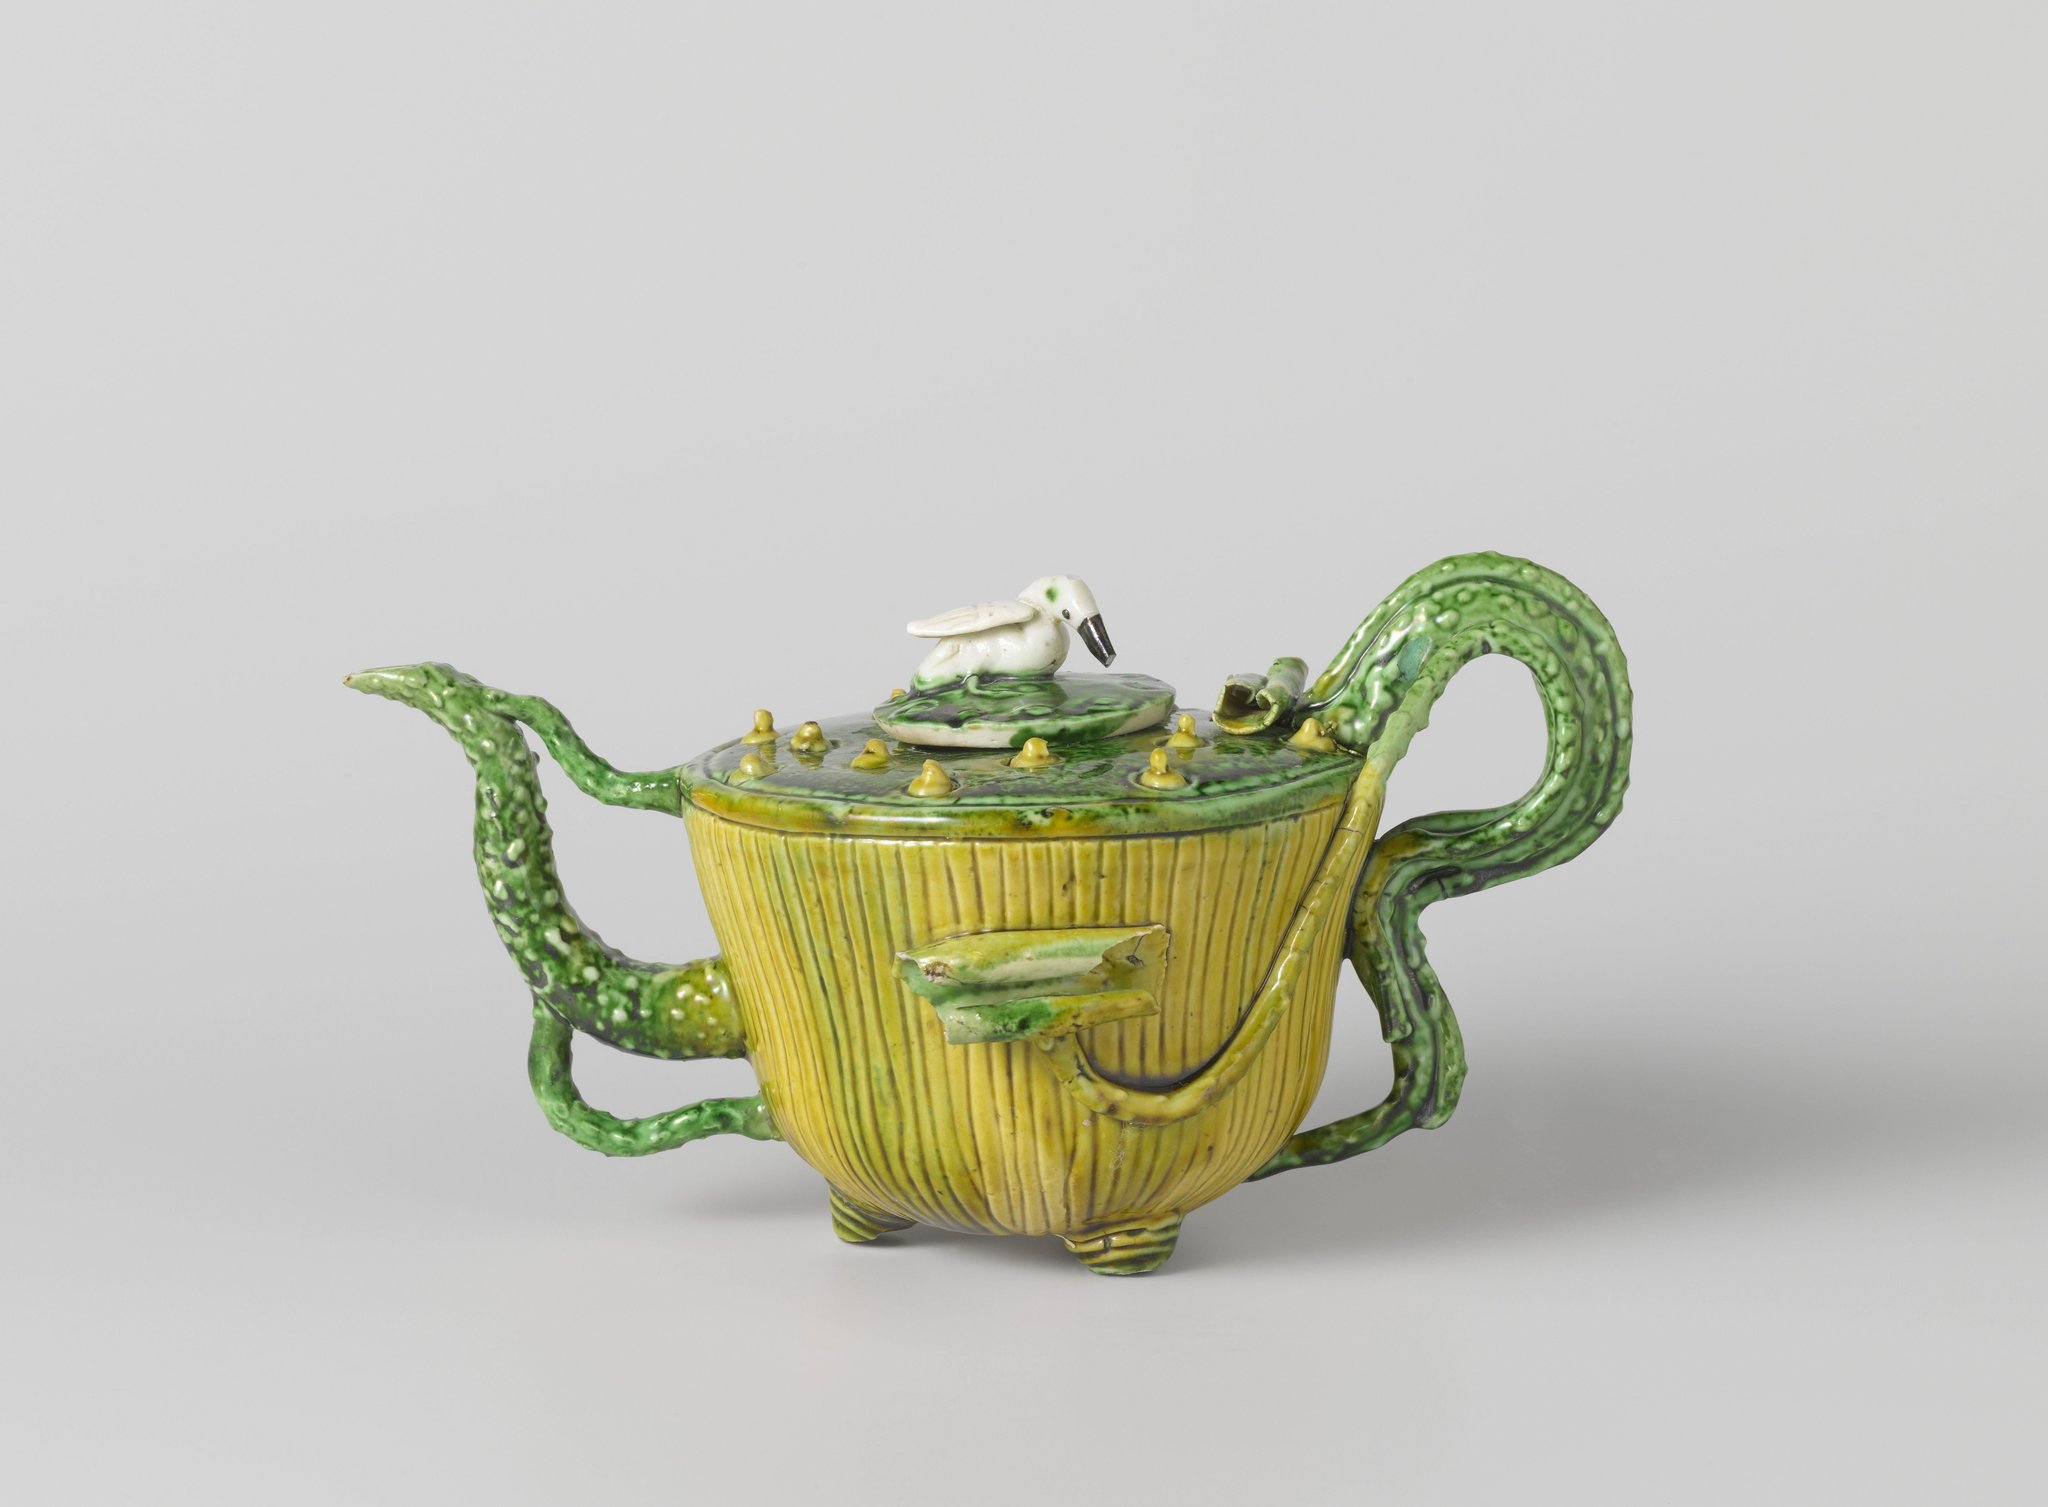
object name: ewer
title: Water jug in the form of a lotus flower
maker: Anonymous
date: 1700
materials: glaze, paint, porcelain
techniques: firing, turning, vitrification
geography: china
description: Trekpot, met deksel en oor, in hard groen en geel, op de wand een lijnenspel met relief.